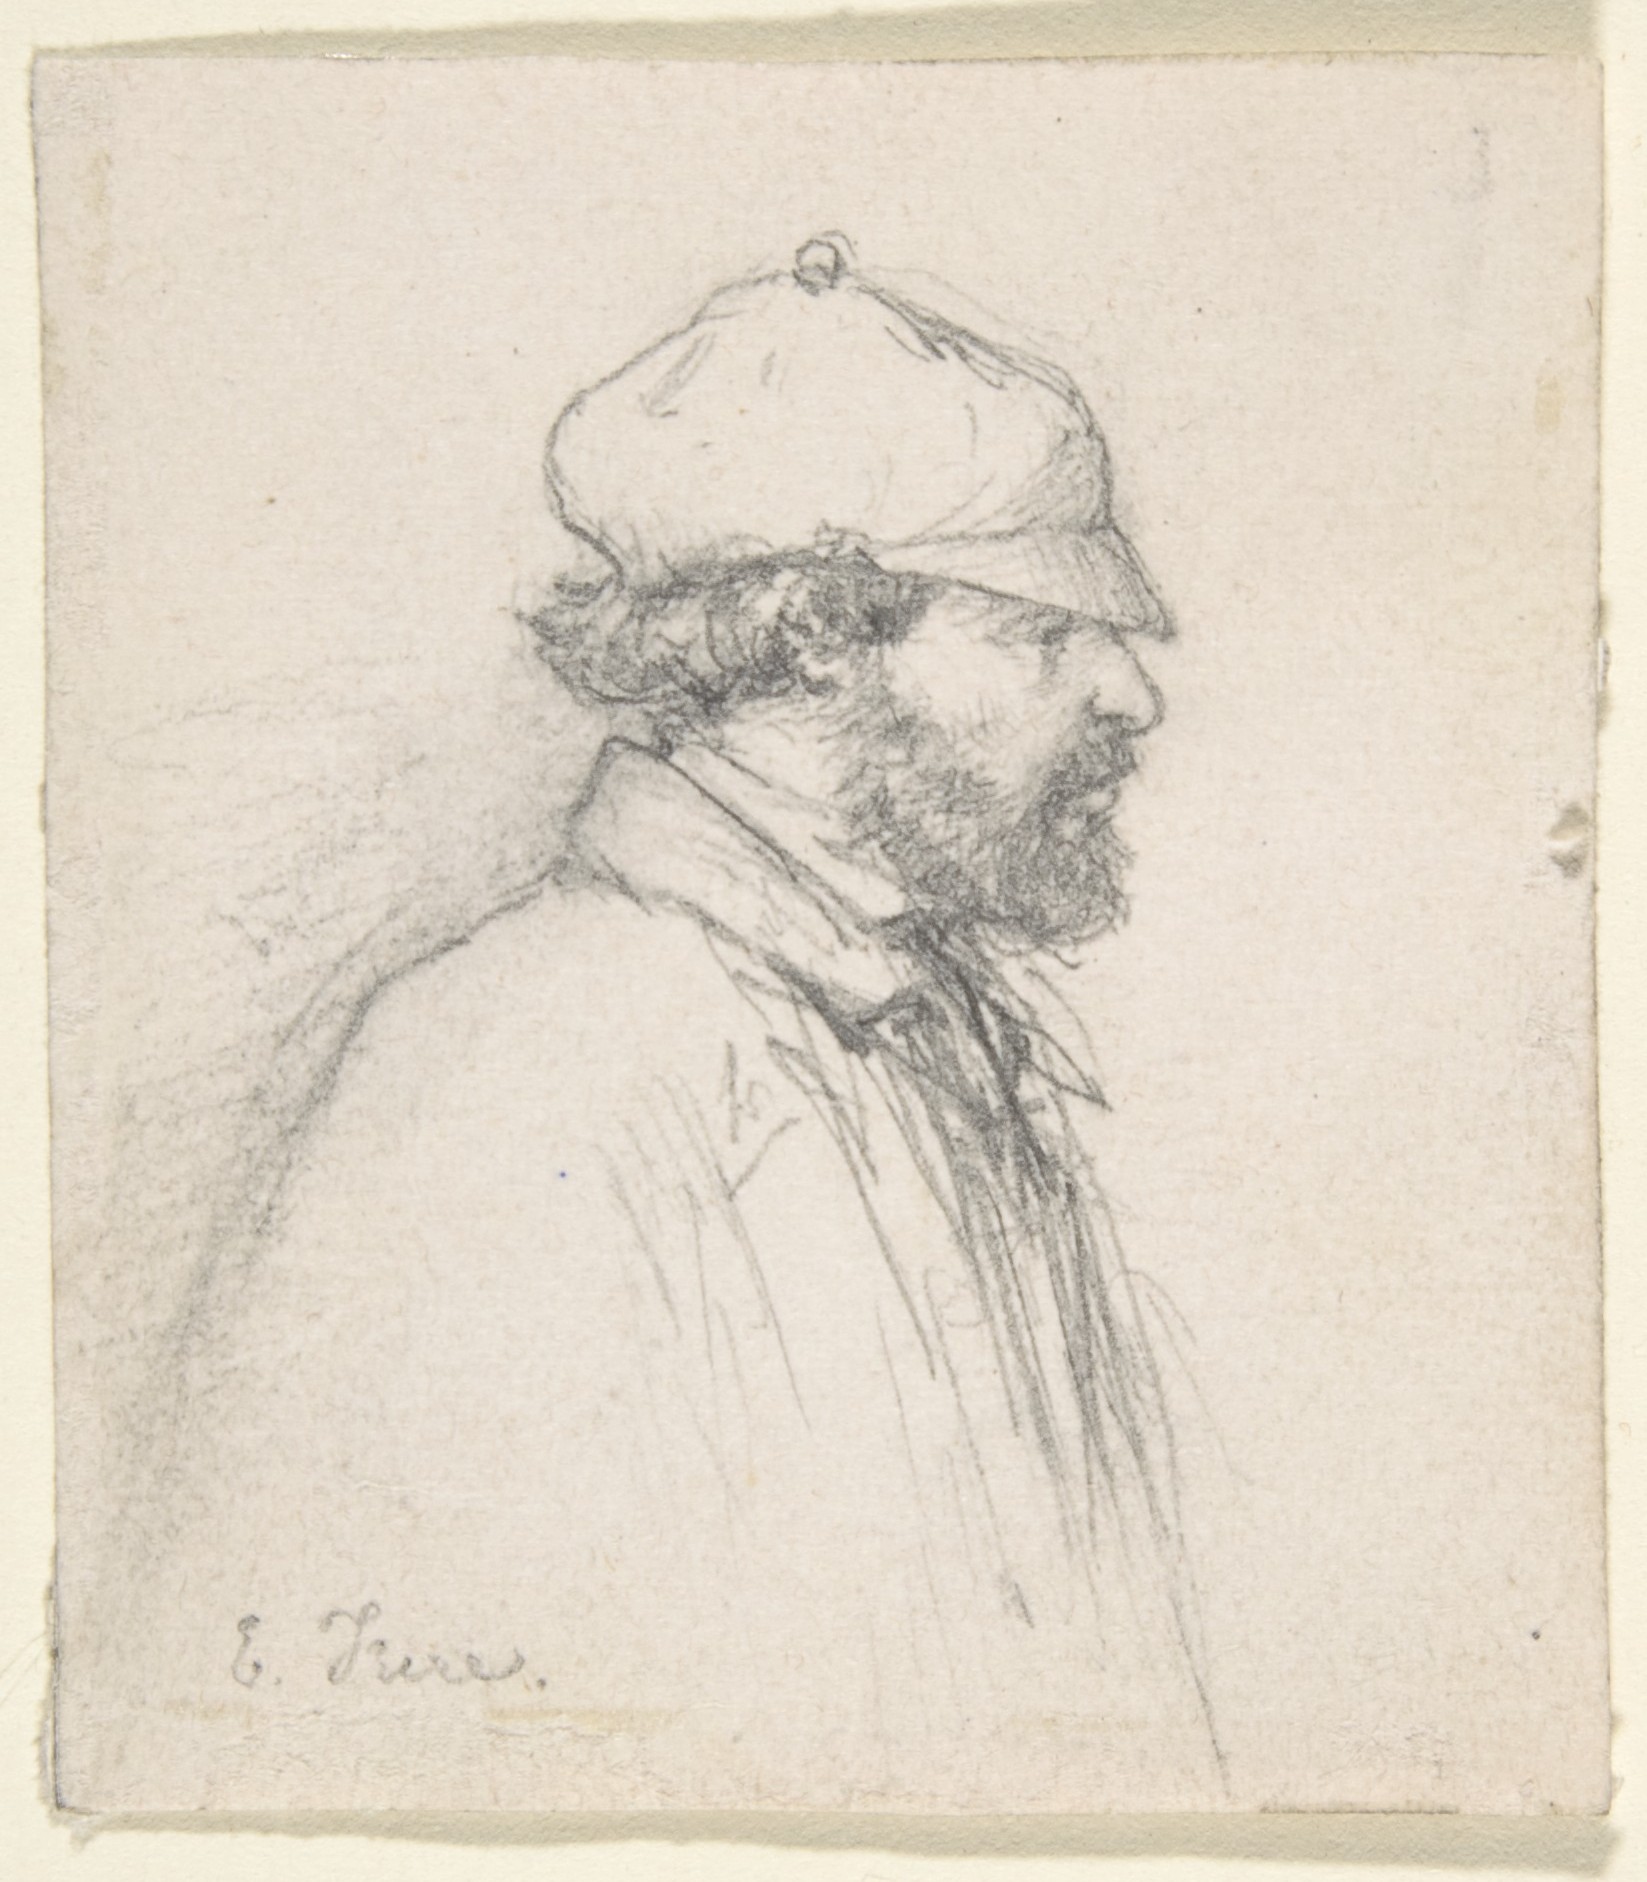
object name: drawing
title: Portrait of E. Triere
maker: anonymous, french, 19th century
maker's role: artist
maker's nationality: french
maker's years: 1800-1900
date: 1801-1900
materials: graphite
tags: men,portraits